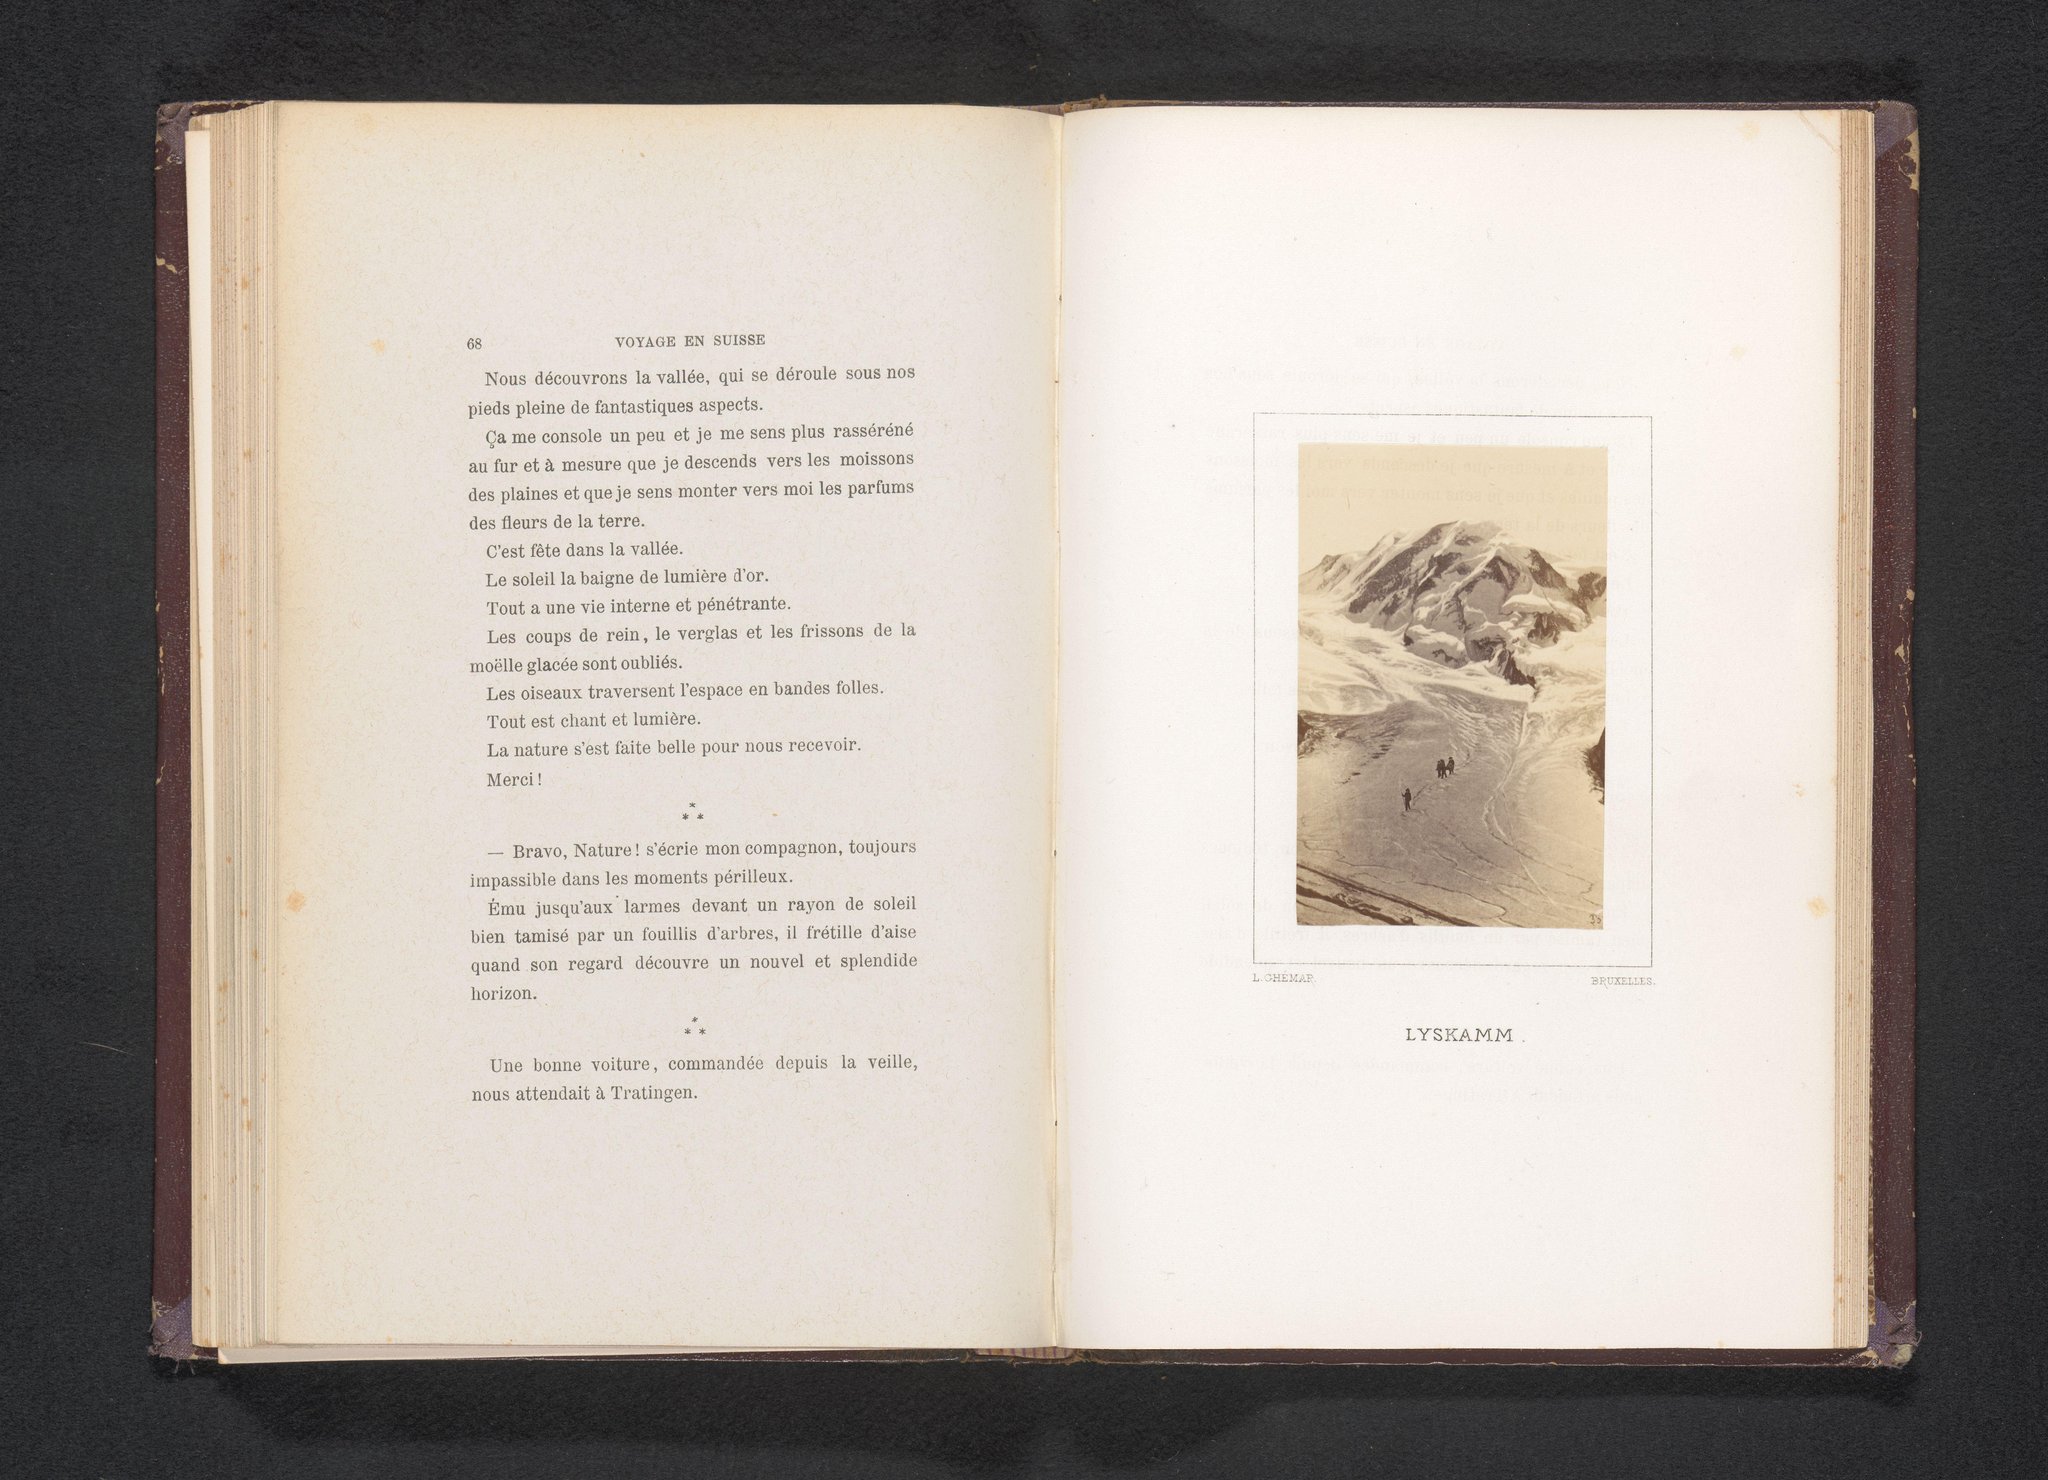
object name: photograph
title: Lyskamm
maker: louis ghémar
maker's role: draughtsman, print maker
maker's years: 1819-1873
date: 1863-1868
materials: photographic support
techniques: albumen print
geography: wallis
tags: mountain climbing, mountaineering, mountain-range, snow peaks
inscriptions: inscription: ‘Bruxelles’